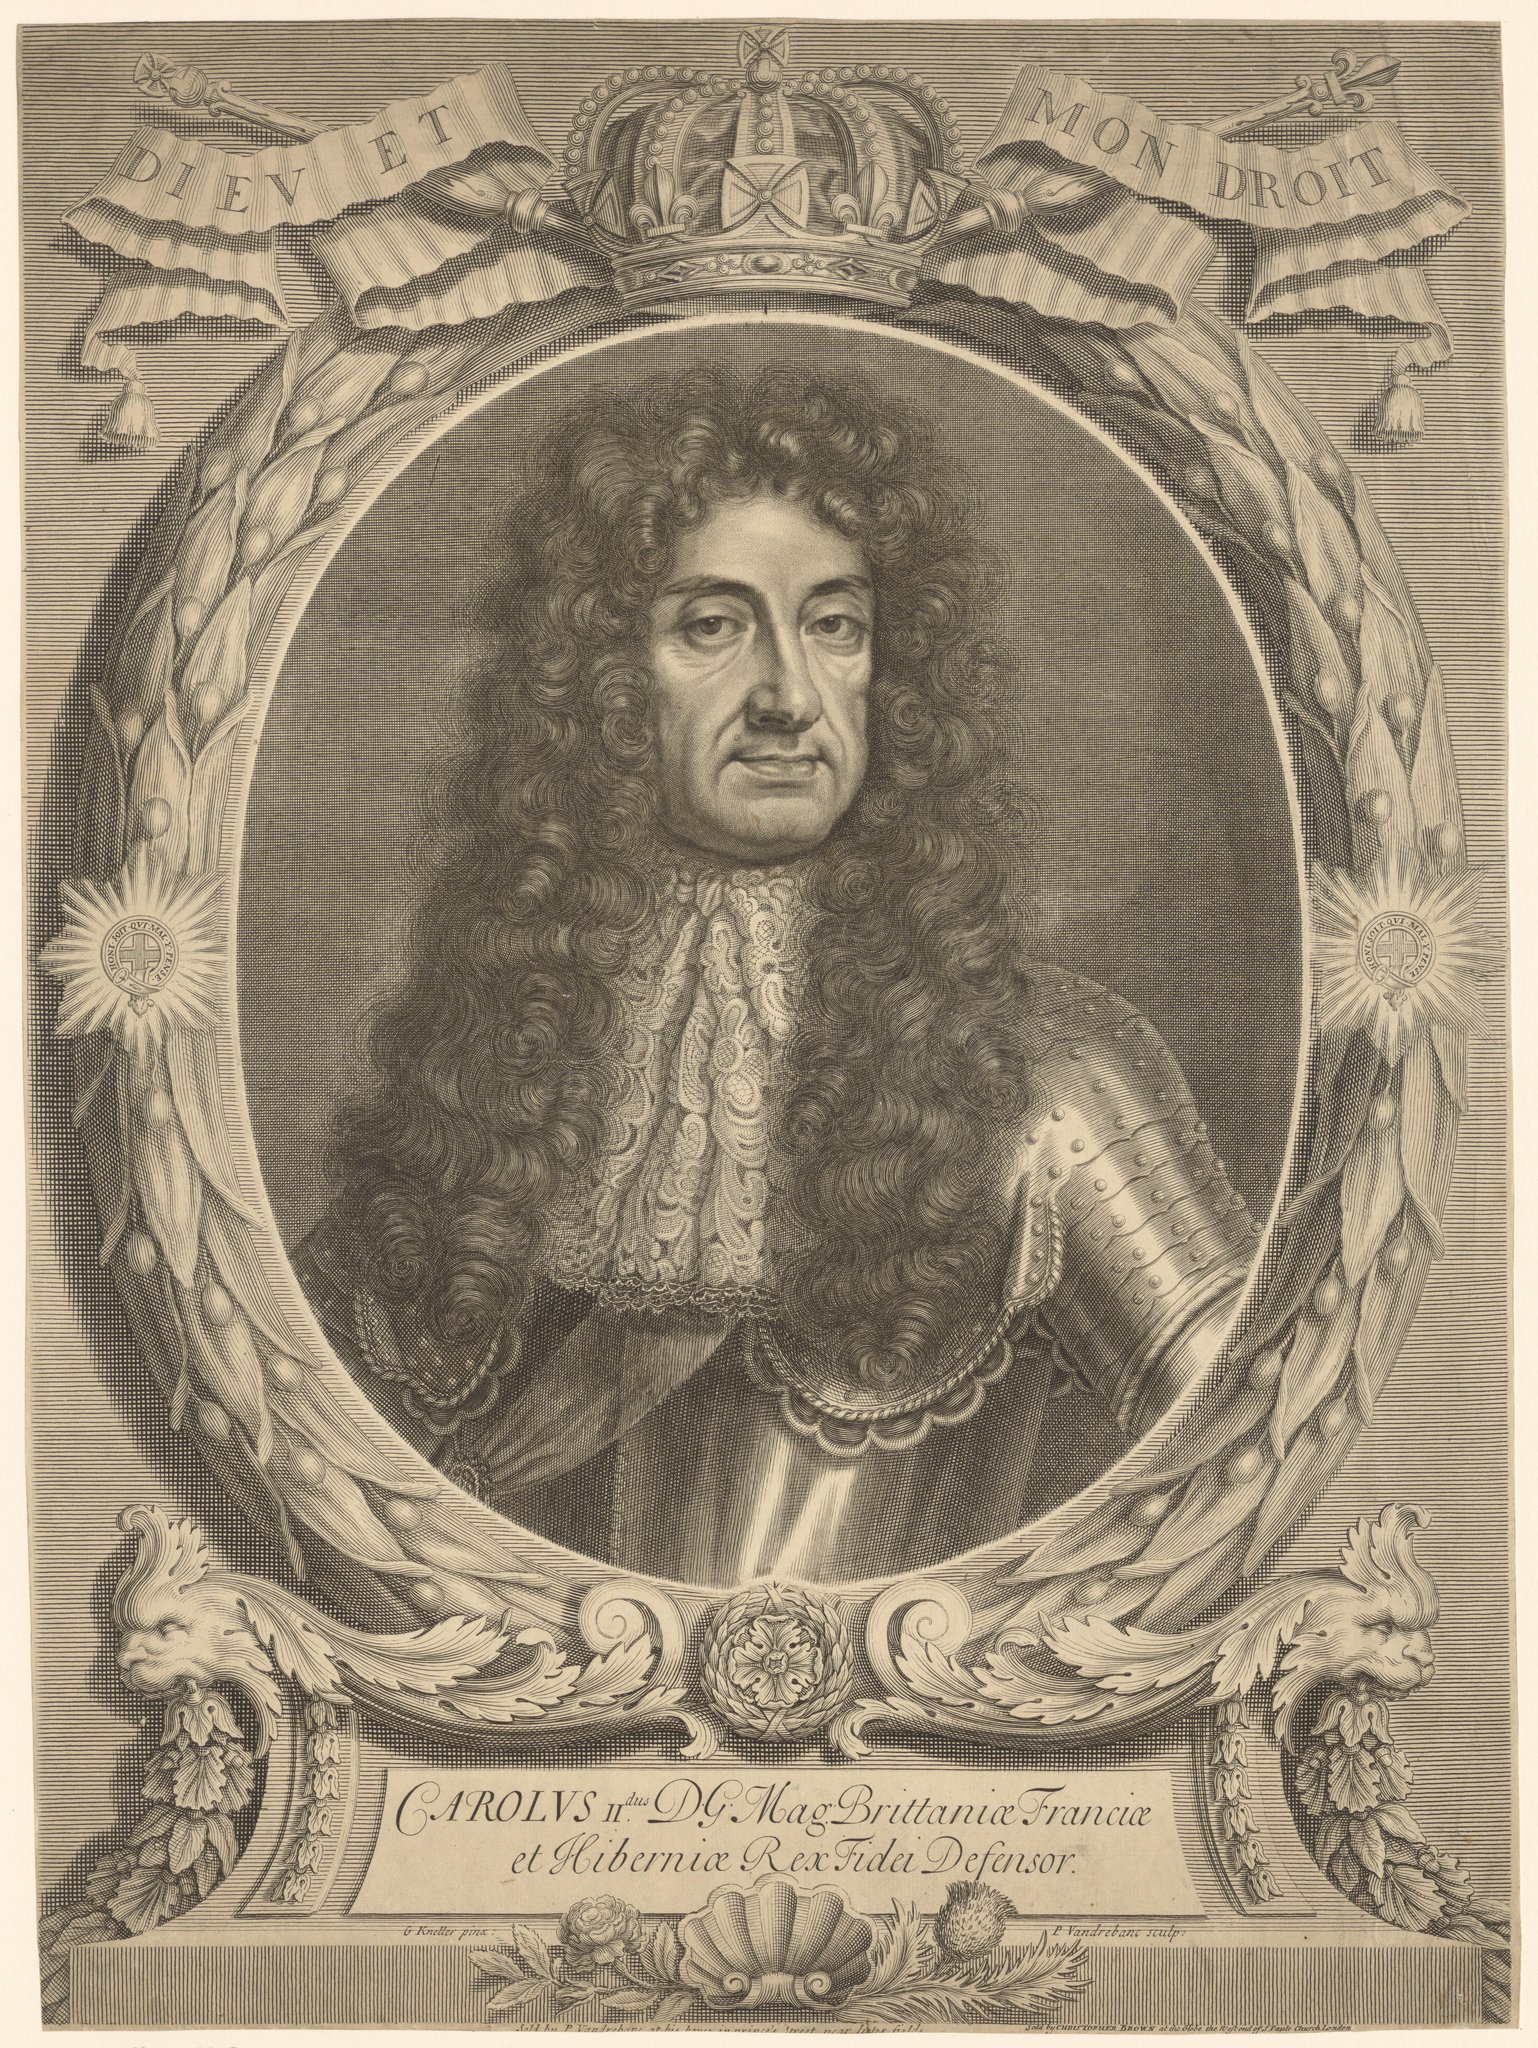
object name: print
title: Carolus IIdus D.G. Mag: Britanniæ Franciæ et Hiberniæ Rex Fidei Defensor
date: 1680-1685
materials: paper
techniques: engraving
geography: london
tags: london, karel ii (koning van engeland), historical persons, king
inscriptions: collector's mark: Lugt 2228